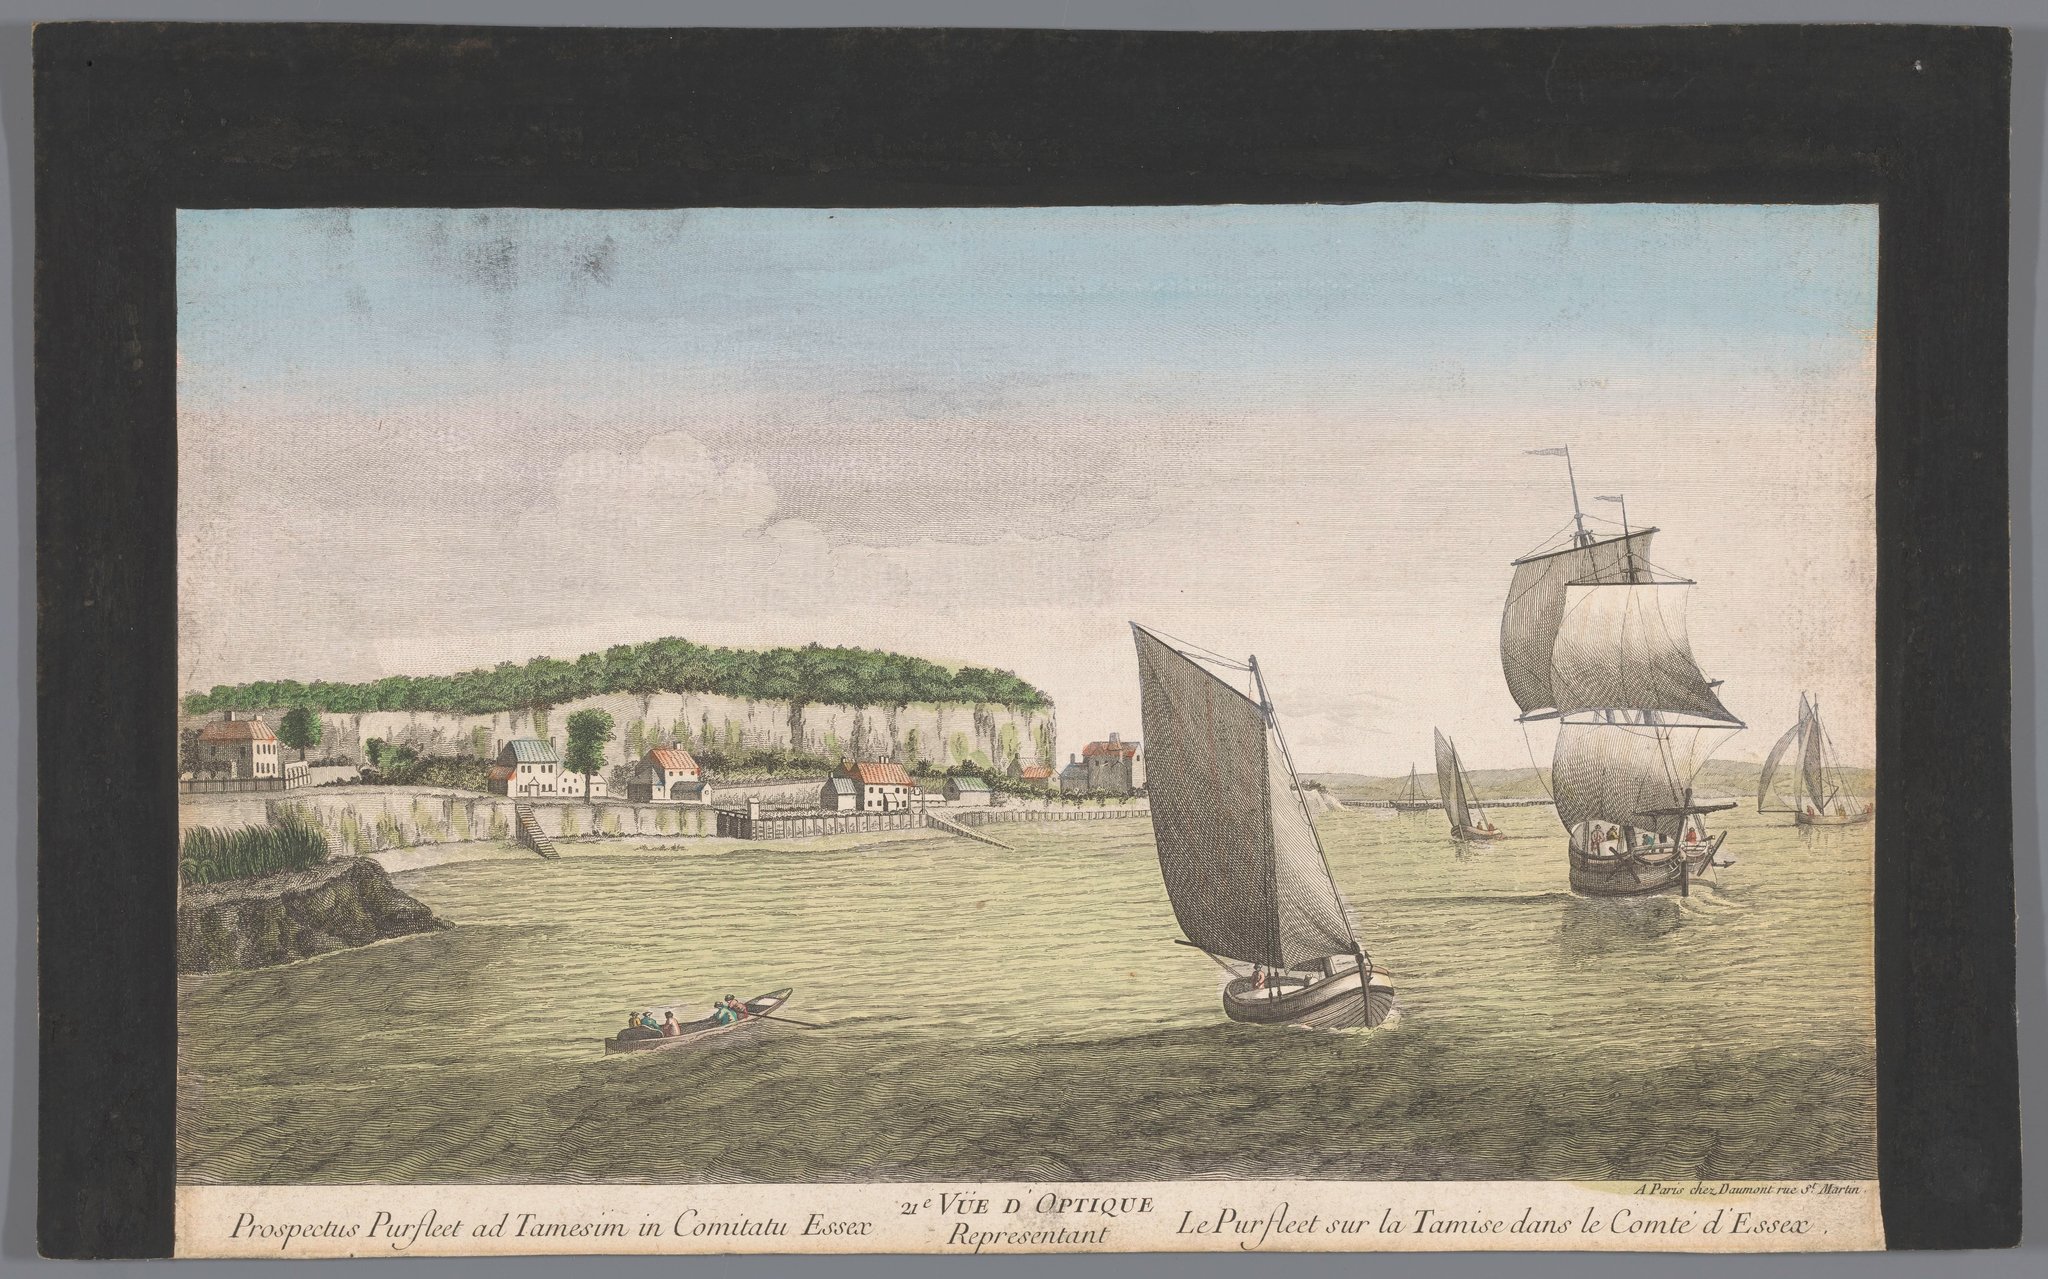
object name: opticaprent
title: 21e Vüe d'optique representant le Purfleet sur la Tamise dans le comte d'Essex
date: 1745-1775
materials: cardboard, paper, watercolor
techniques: brush, etching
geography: paris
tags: sailing-ship, sailing-boat, canals, waters (in village) (+ city(-scape) with figures, staffage), thames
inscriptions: collector's mark: Lugt 2228